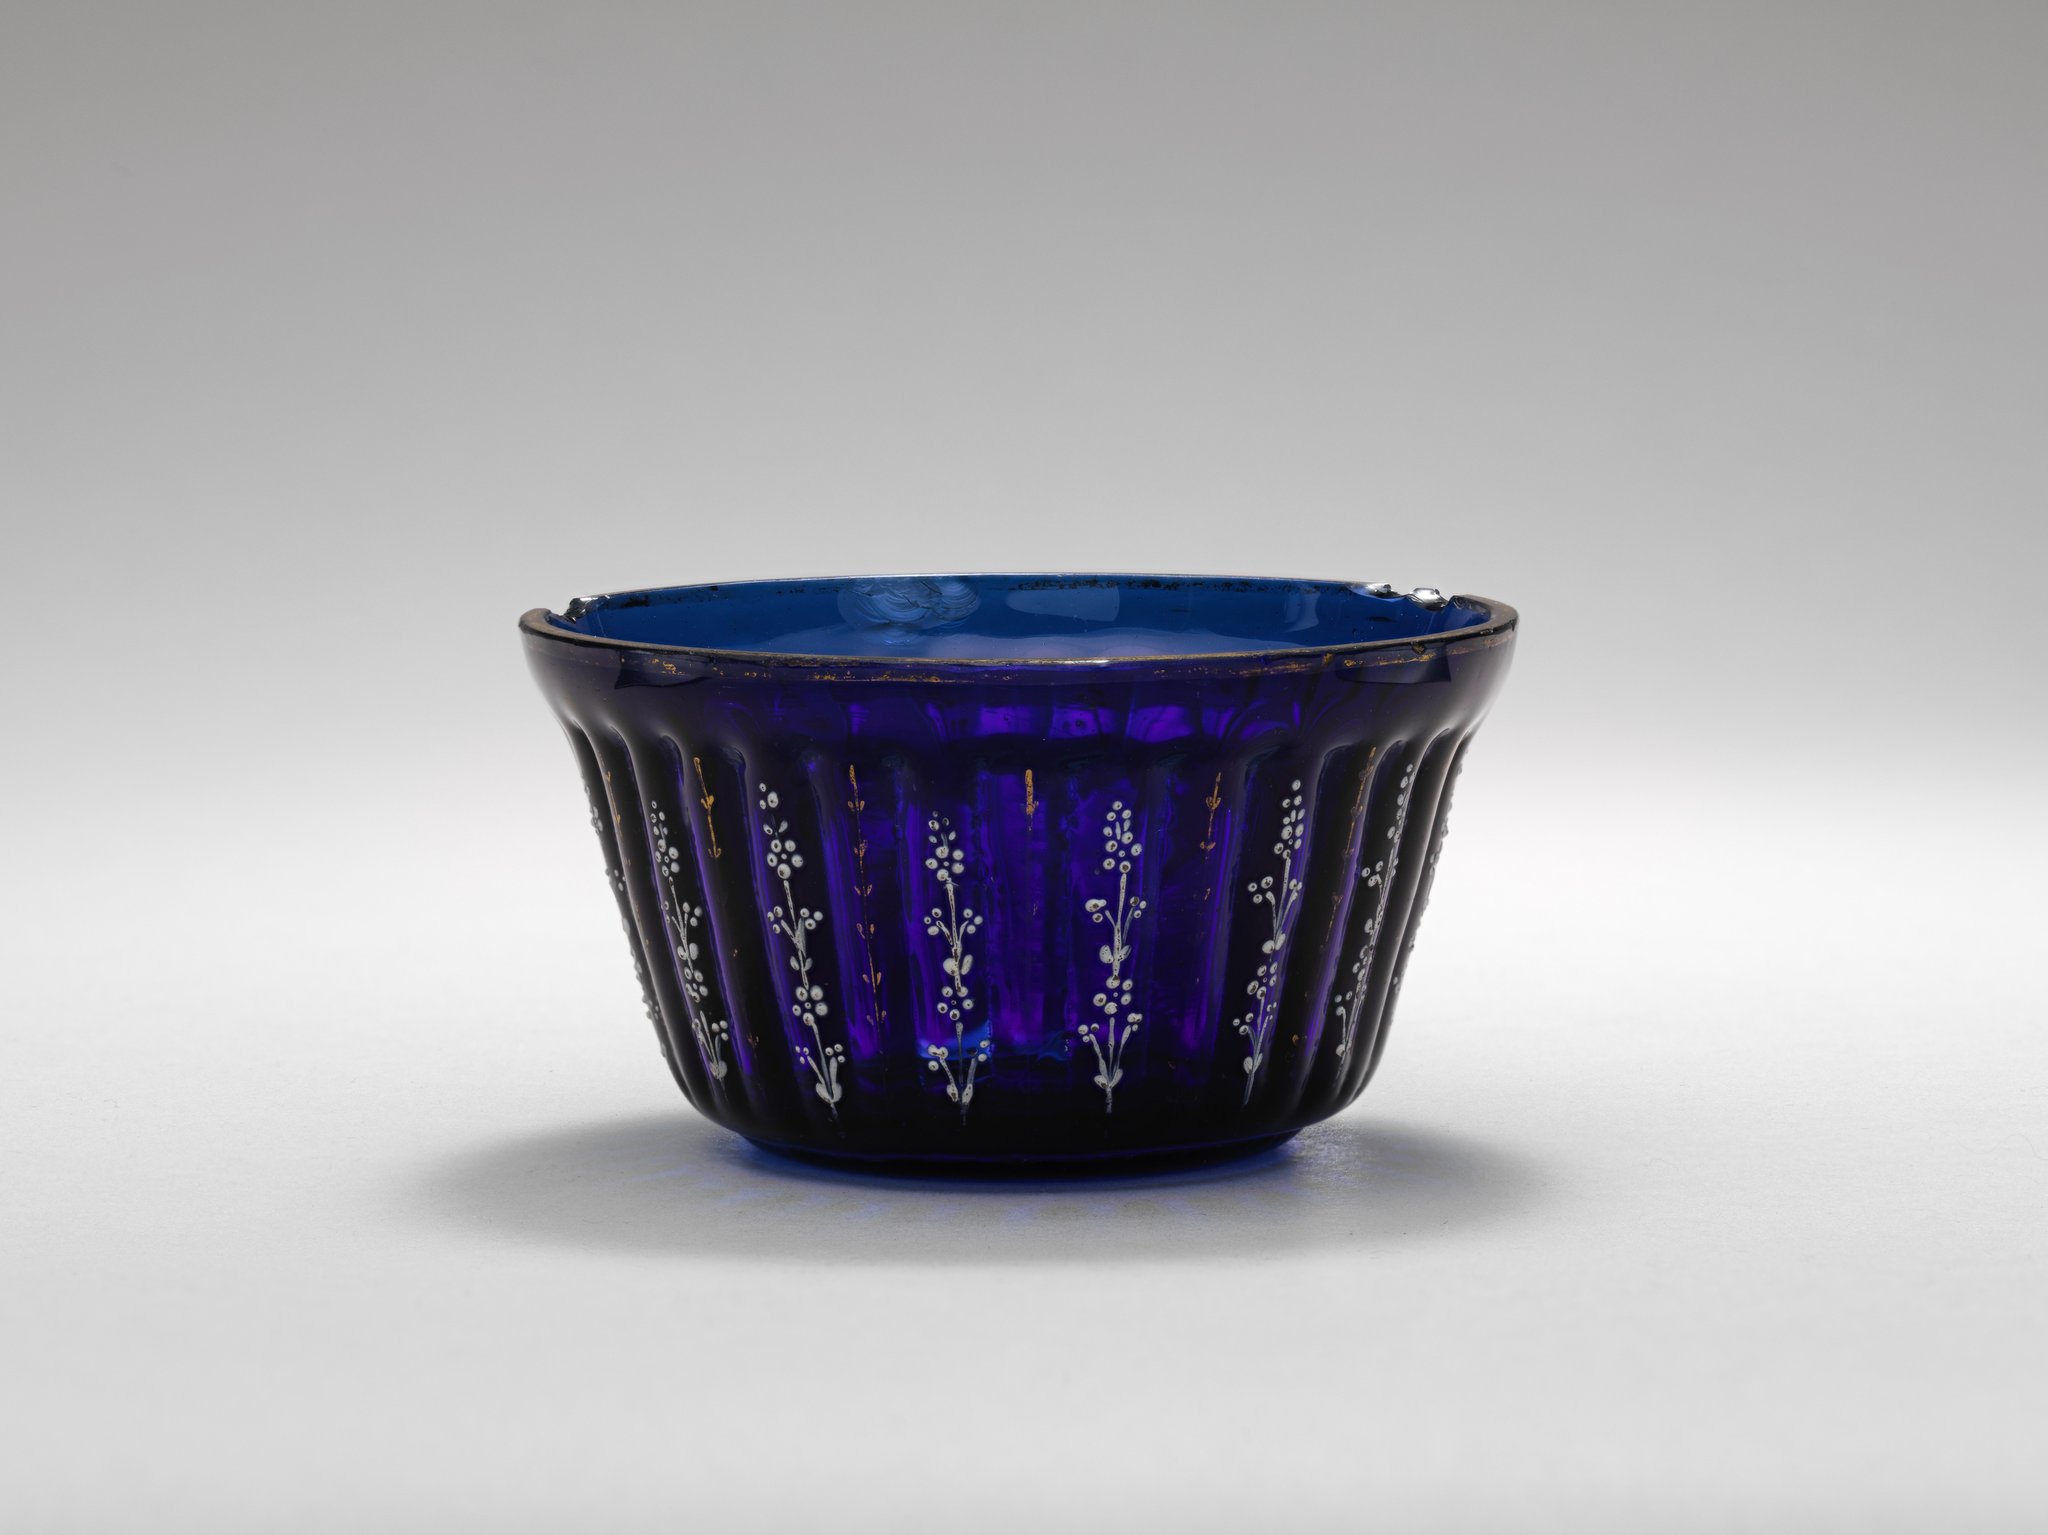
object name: bowl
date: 1501-1700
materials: glass